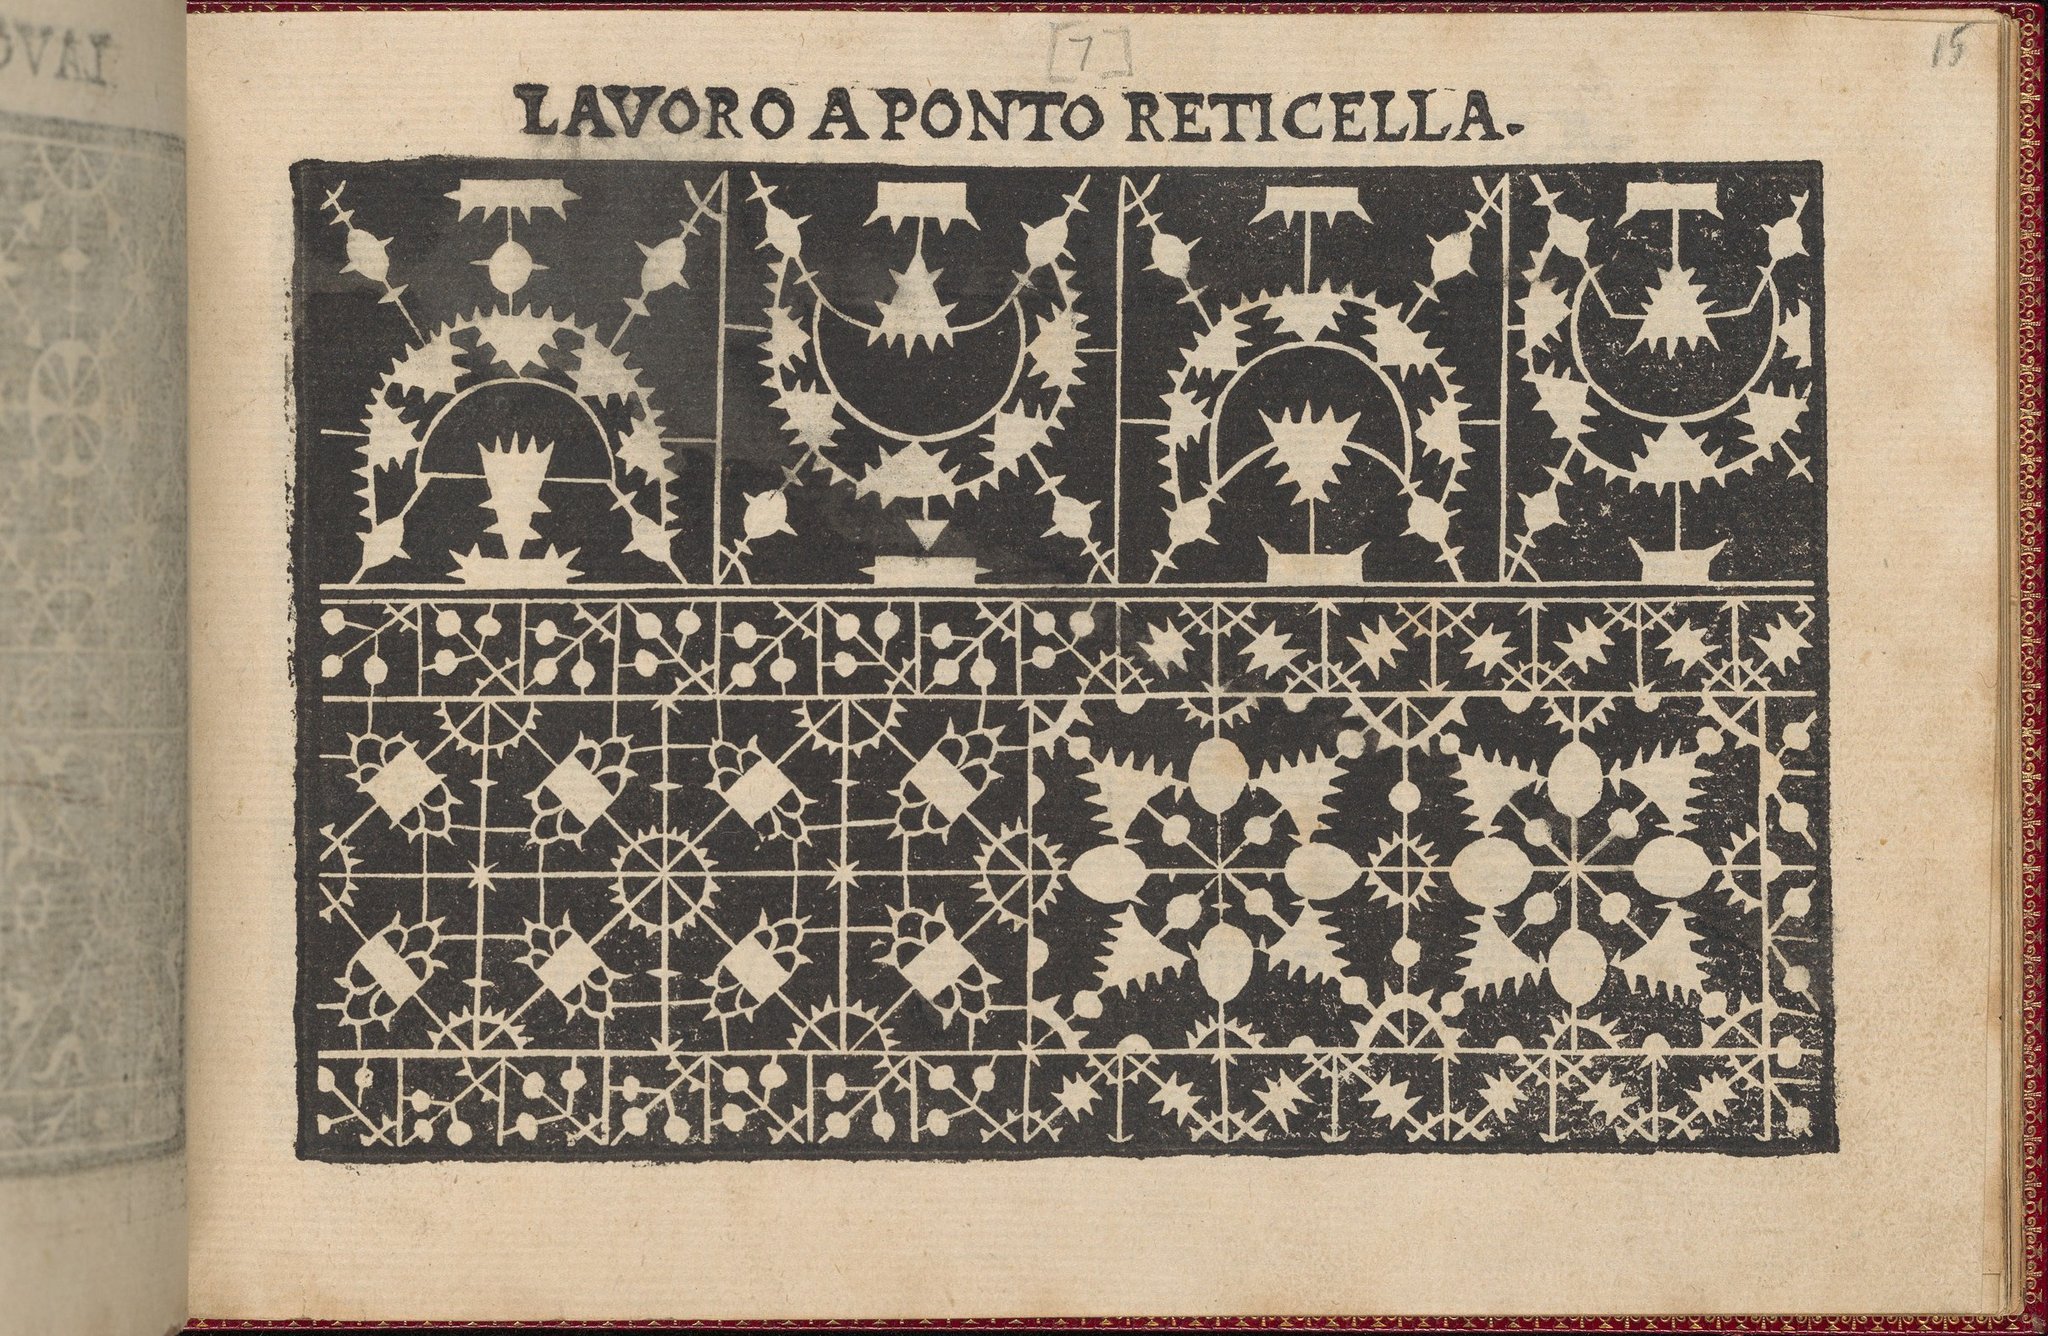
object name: book print ornament architecture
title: Pretiosa Gemma delle virtuose donne, page 17 (recto)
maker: isabella catanea parasole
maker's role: author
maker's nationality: italian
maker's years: 1565-1625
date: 1600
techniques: woodcut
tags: ornament